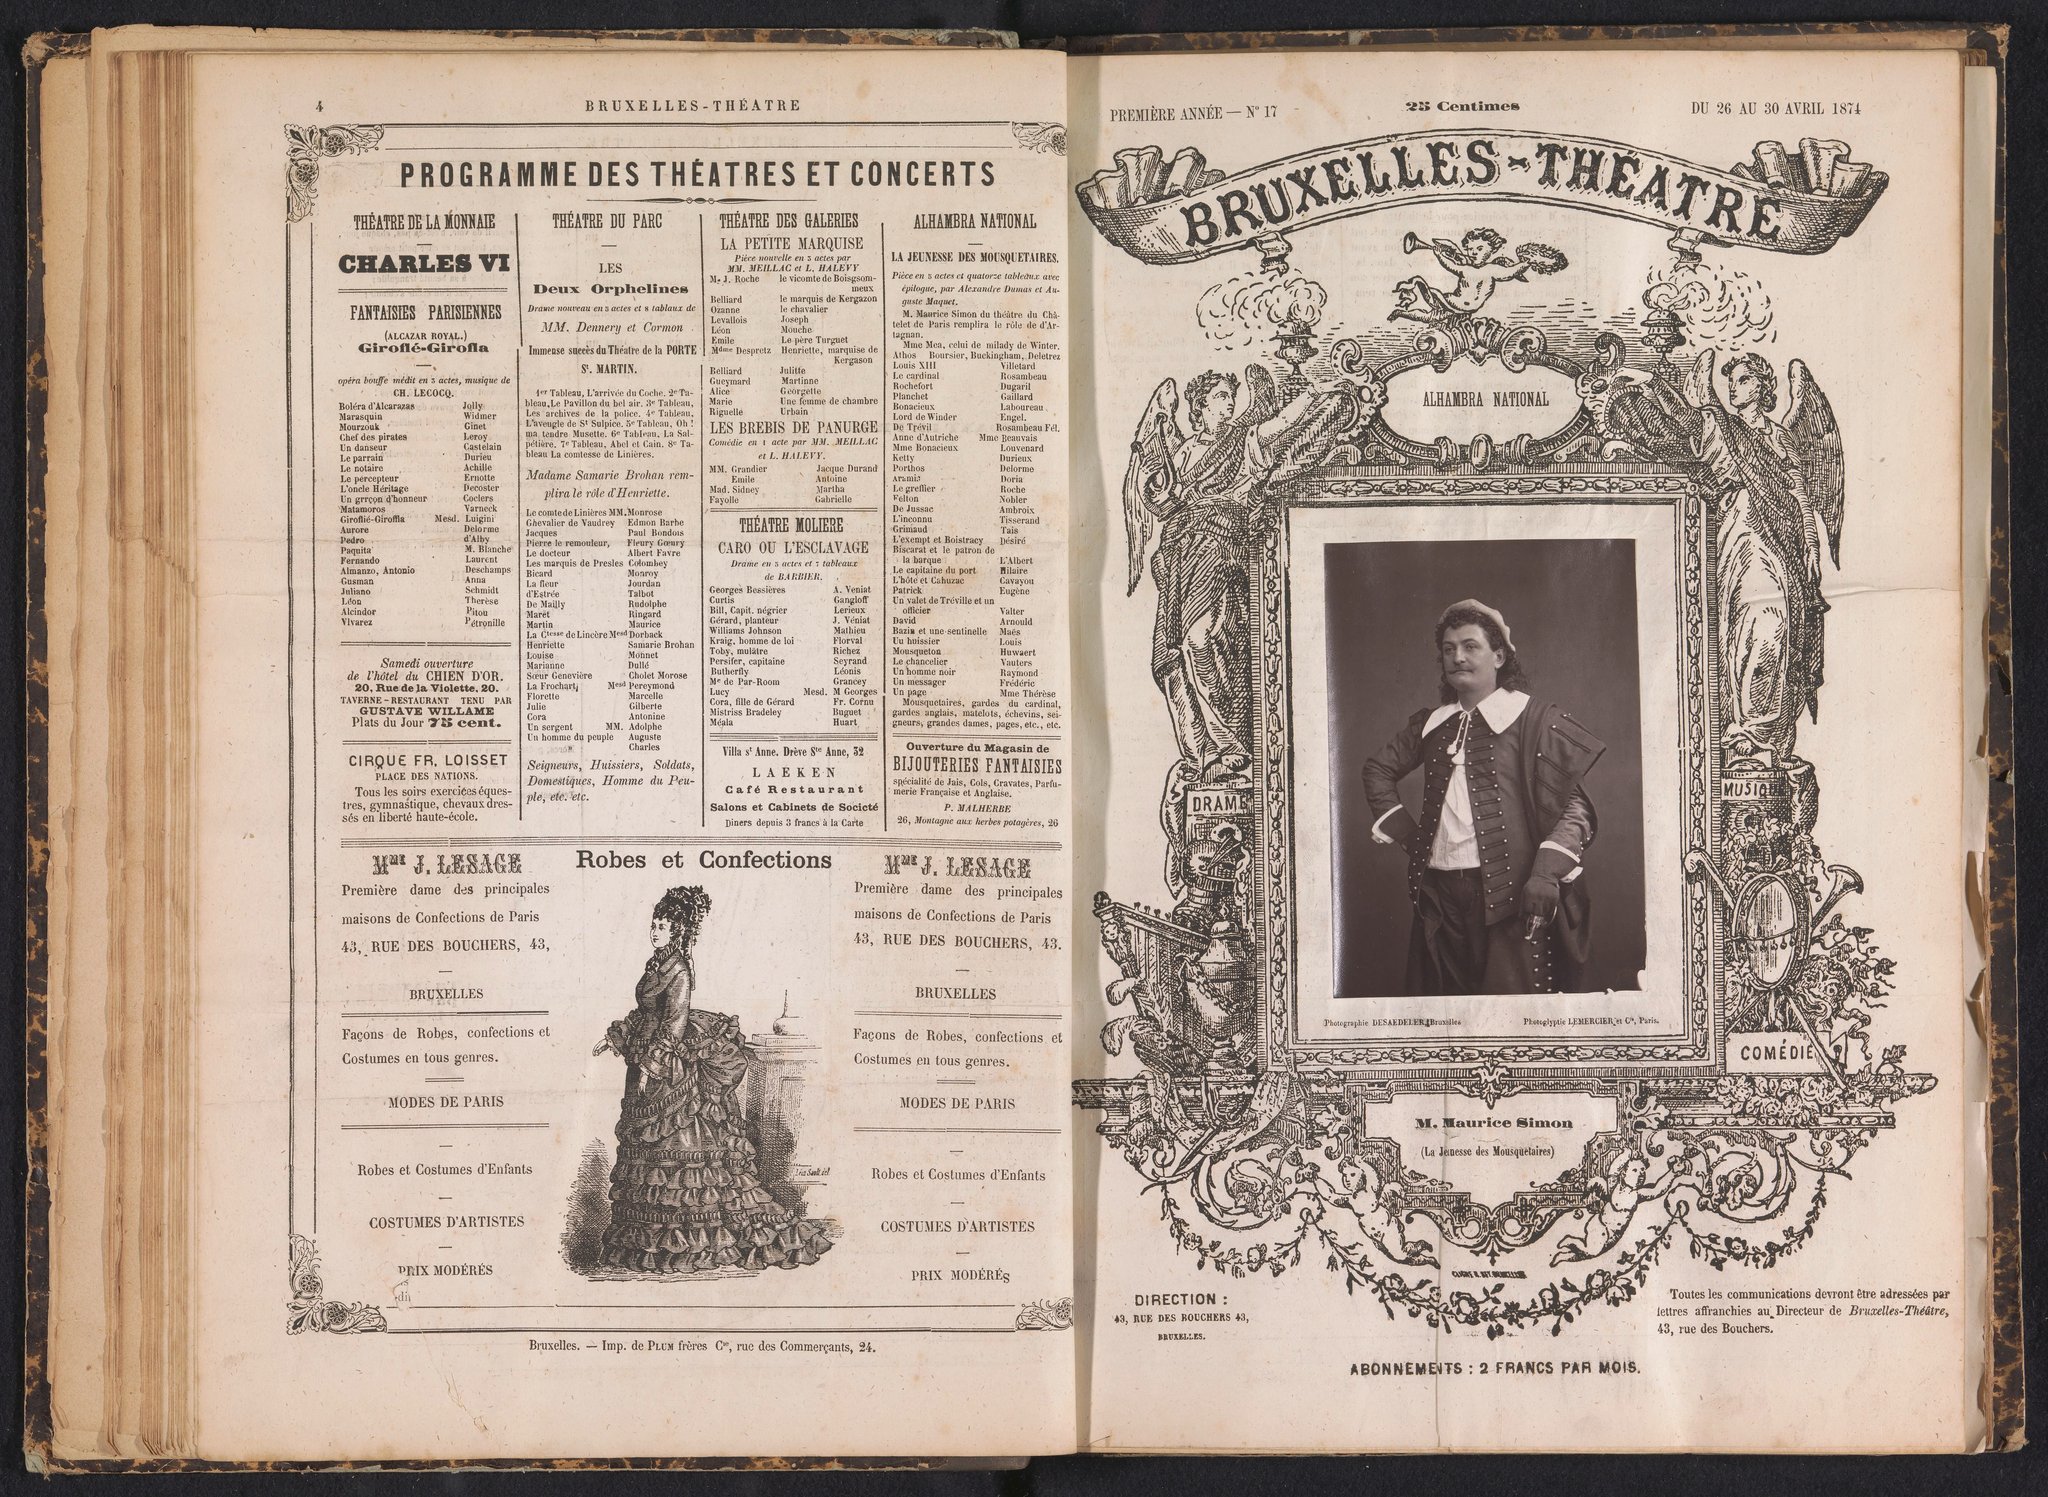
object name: photomechanical print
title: Portret van Maurice Simon in La jeunesse des mousquetaires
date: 1869-1874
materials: paper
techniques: woodburytype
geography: brussels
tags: portrait of actor, actress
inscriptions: number: ‘No 17’